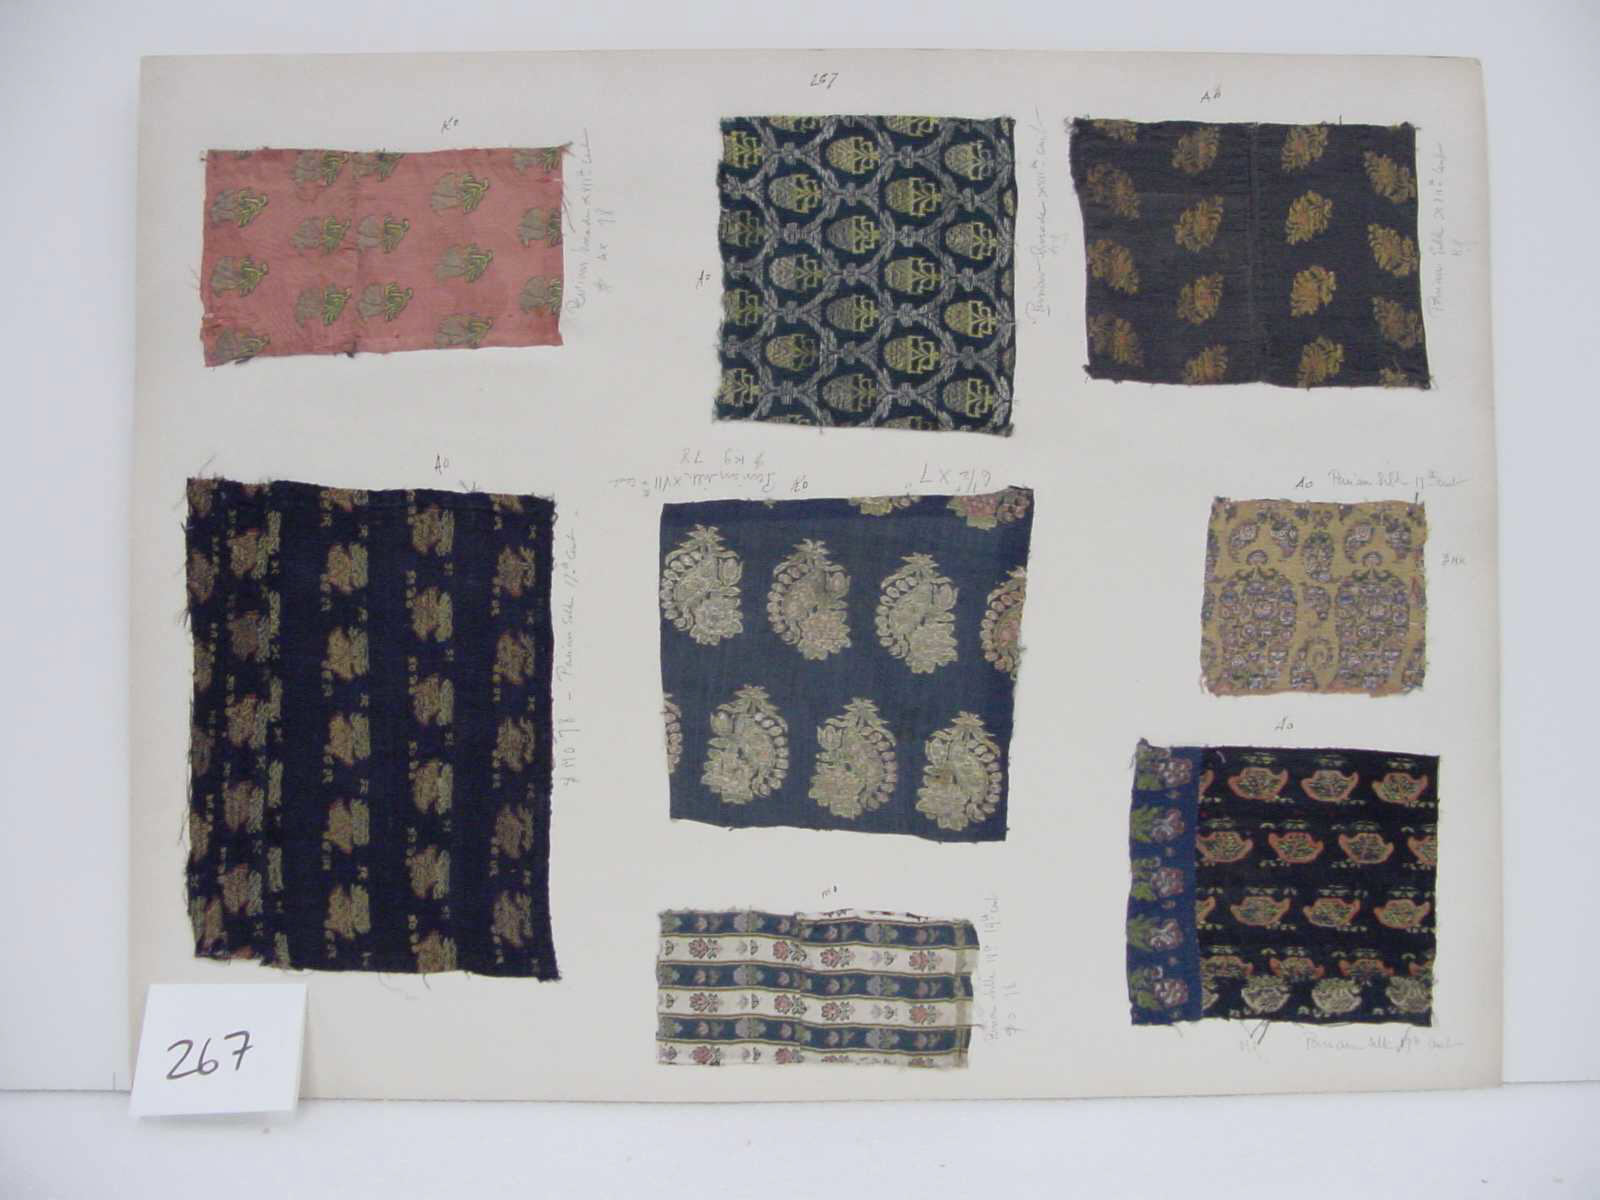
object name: textile fragment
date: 1601-1800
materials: silk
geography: iran